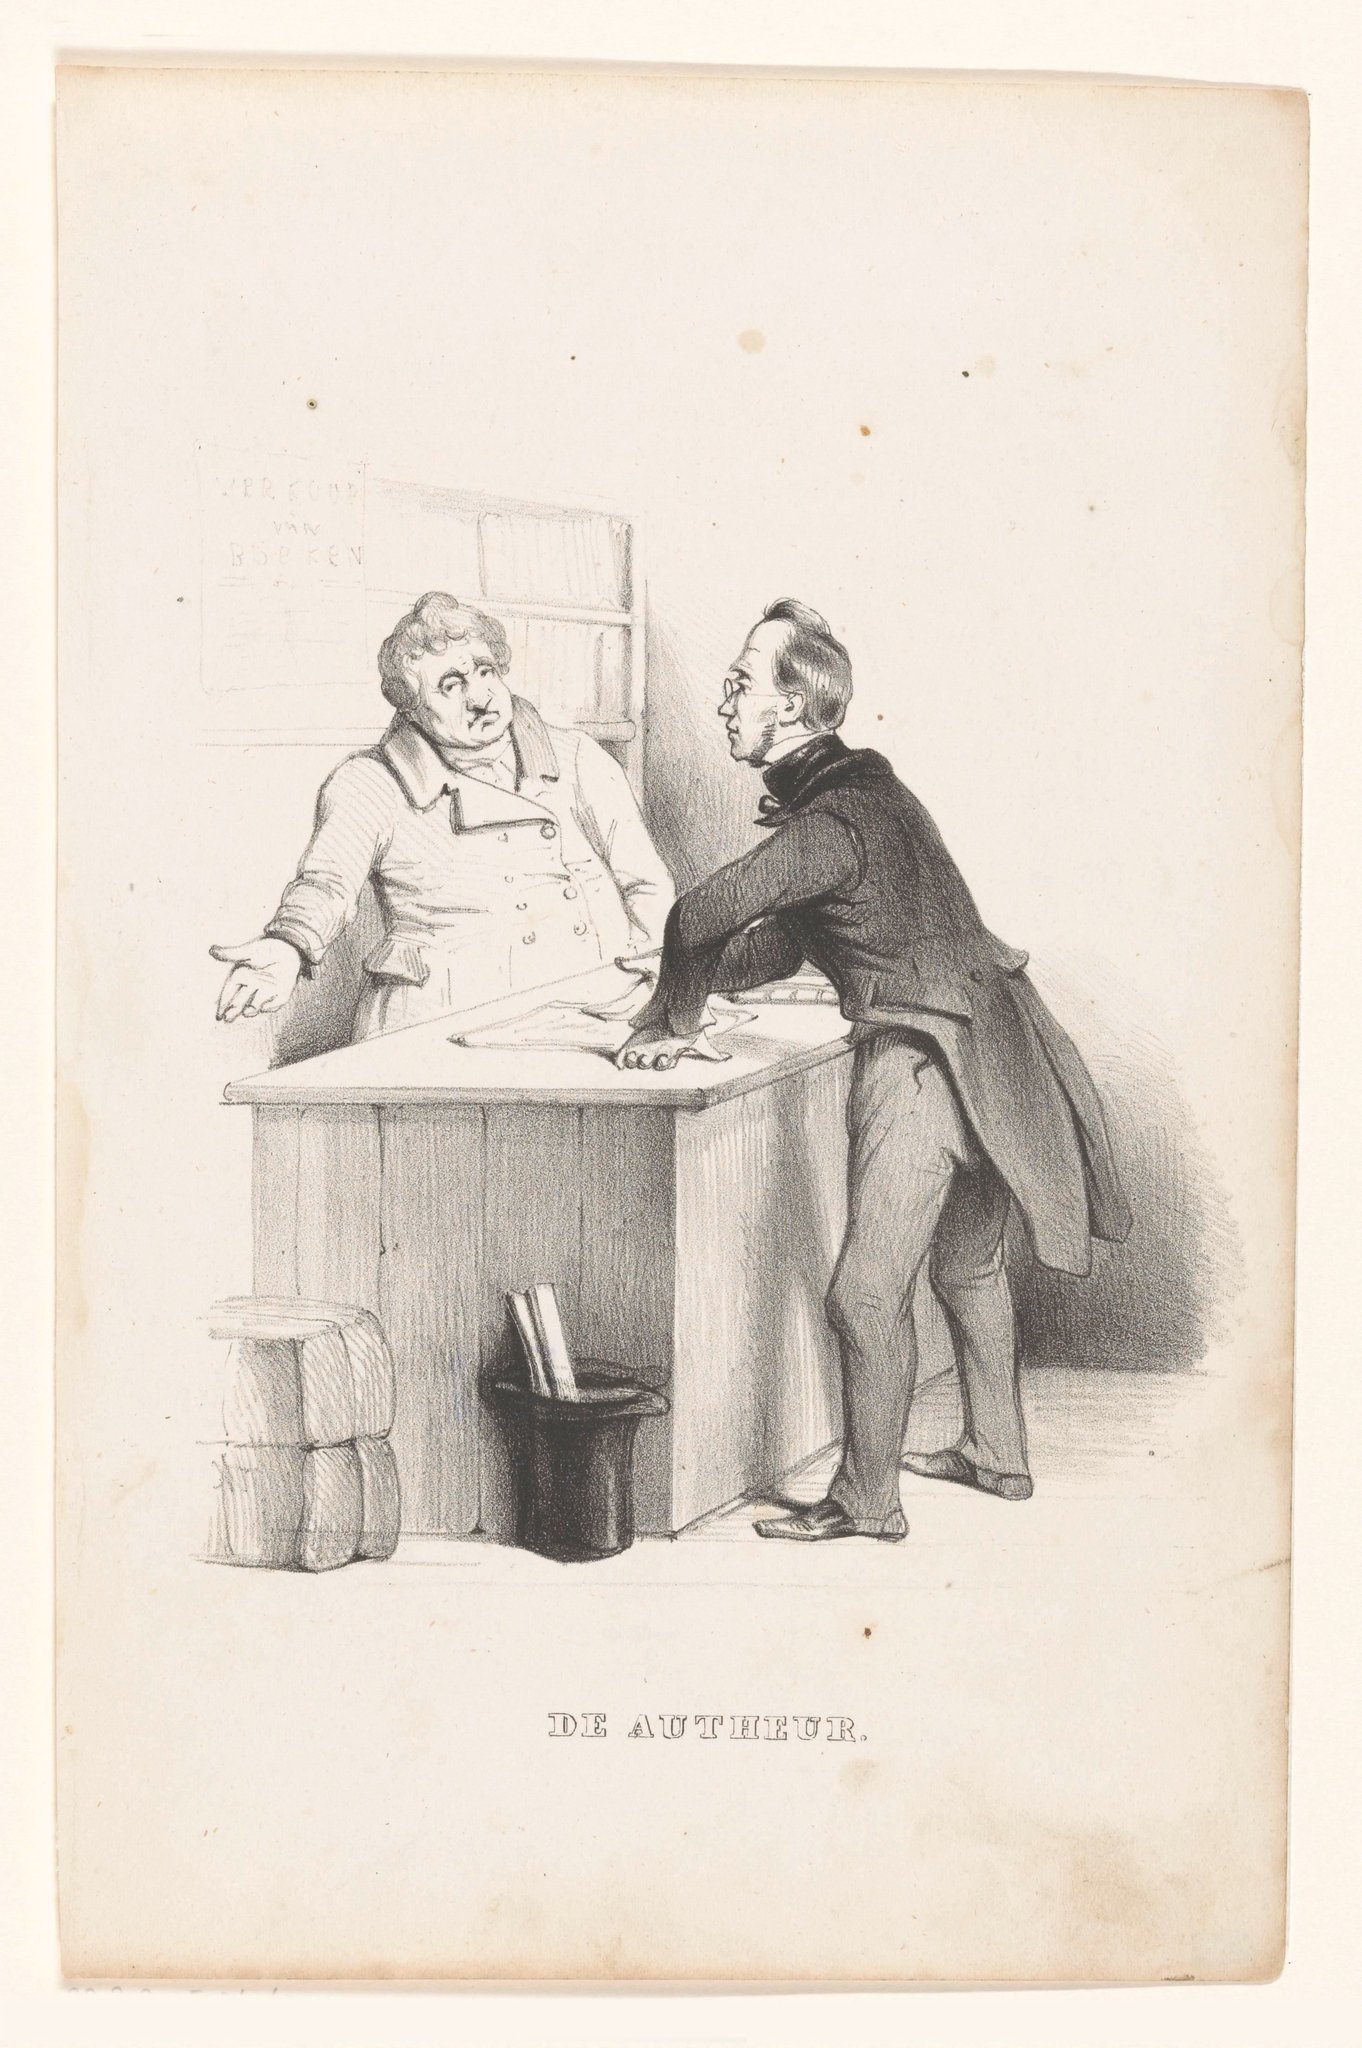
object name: print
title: Schrijver in discussie met een boekhandelaar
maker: Anonymous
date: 1850-1899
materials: paper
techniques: lithograph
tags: book-shop, bookseller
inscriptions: collector's mark: Lugt 4780, collector's mark: Lugt 4779, collector's mark: Lugt 2228